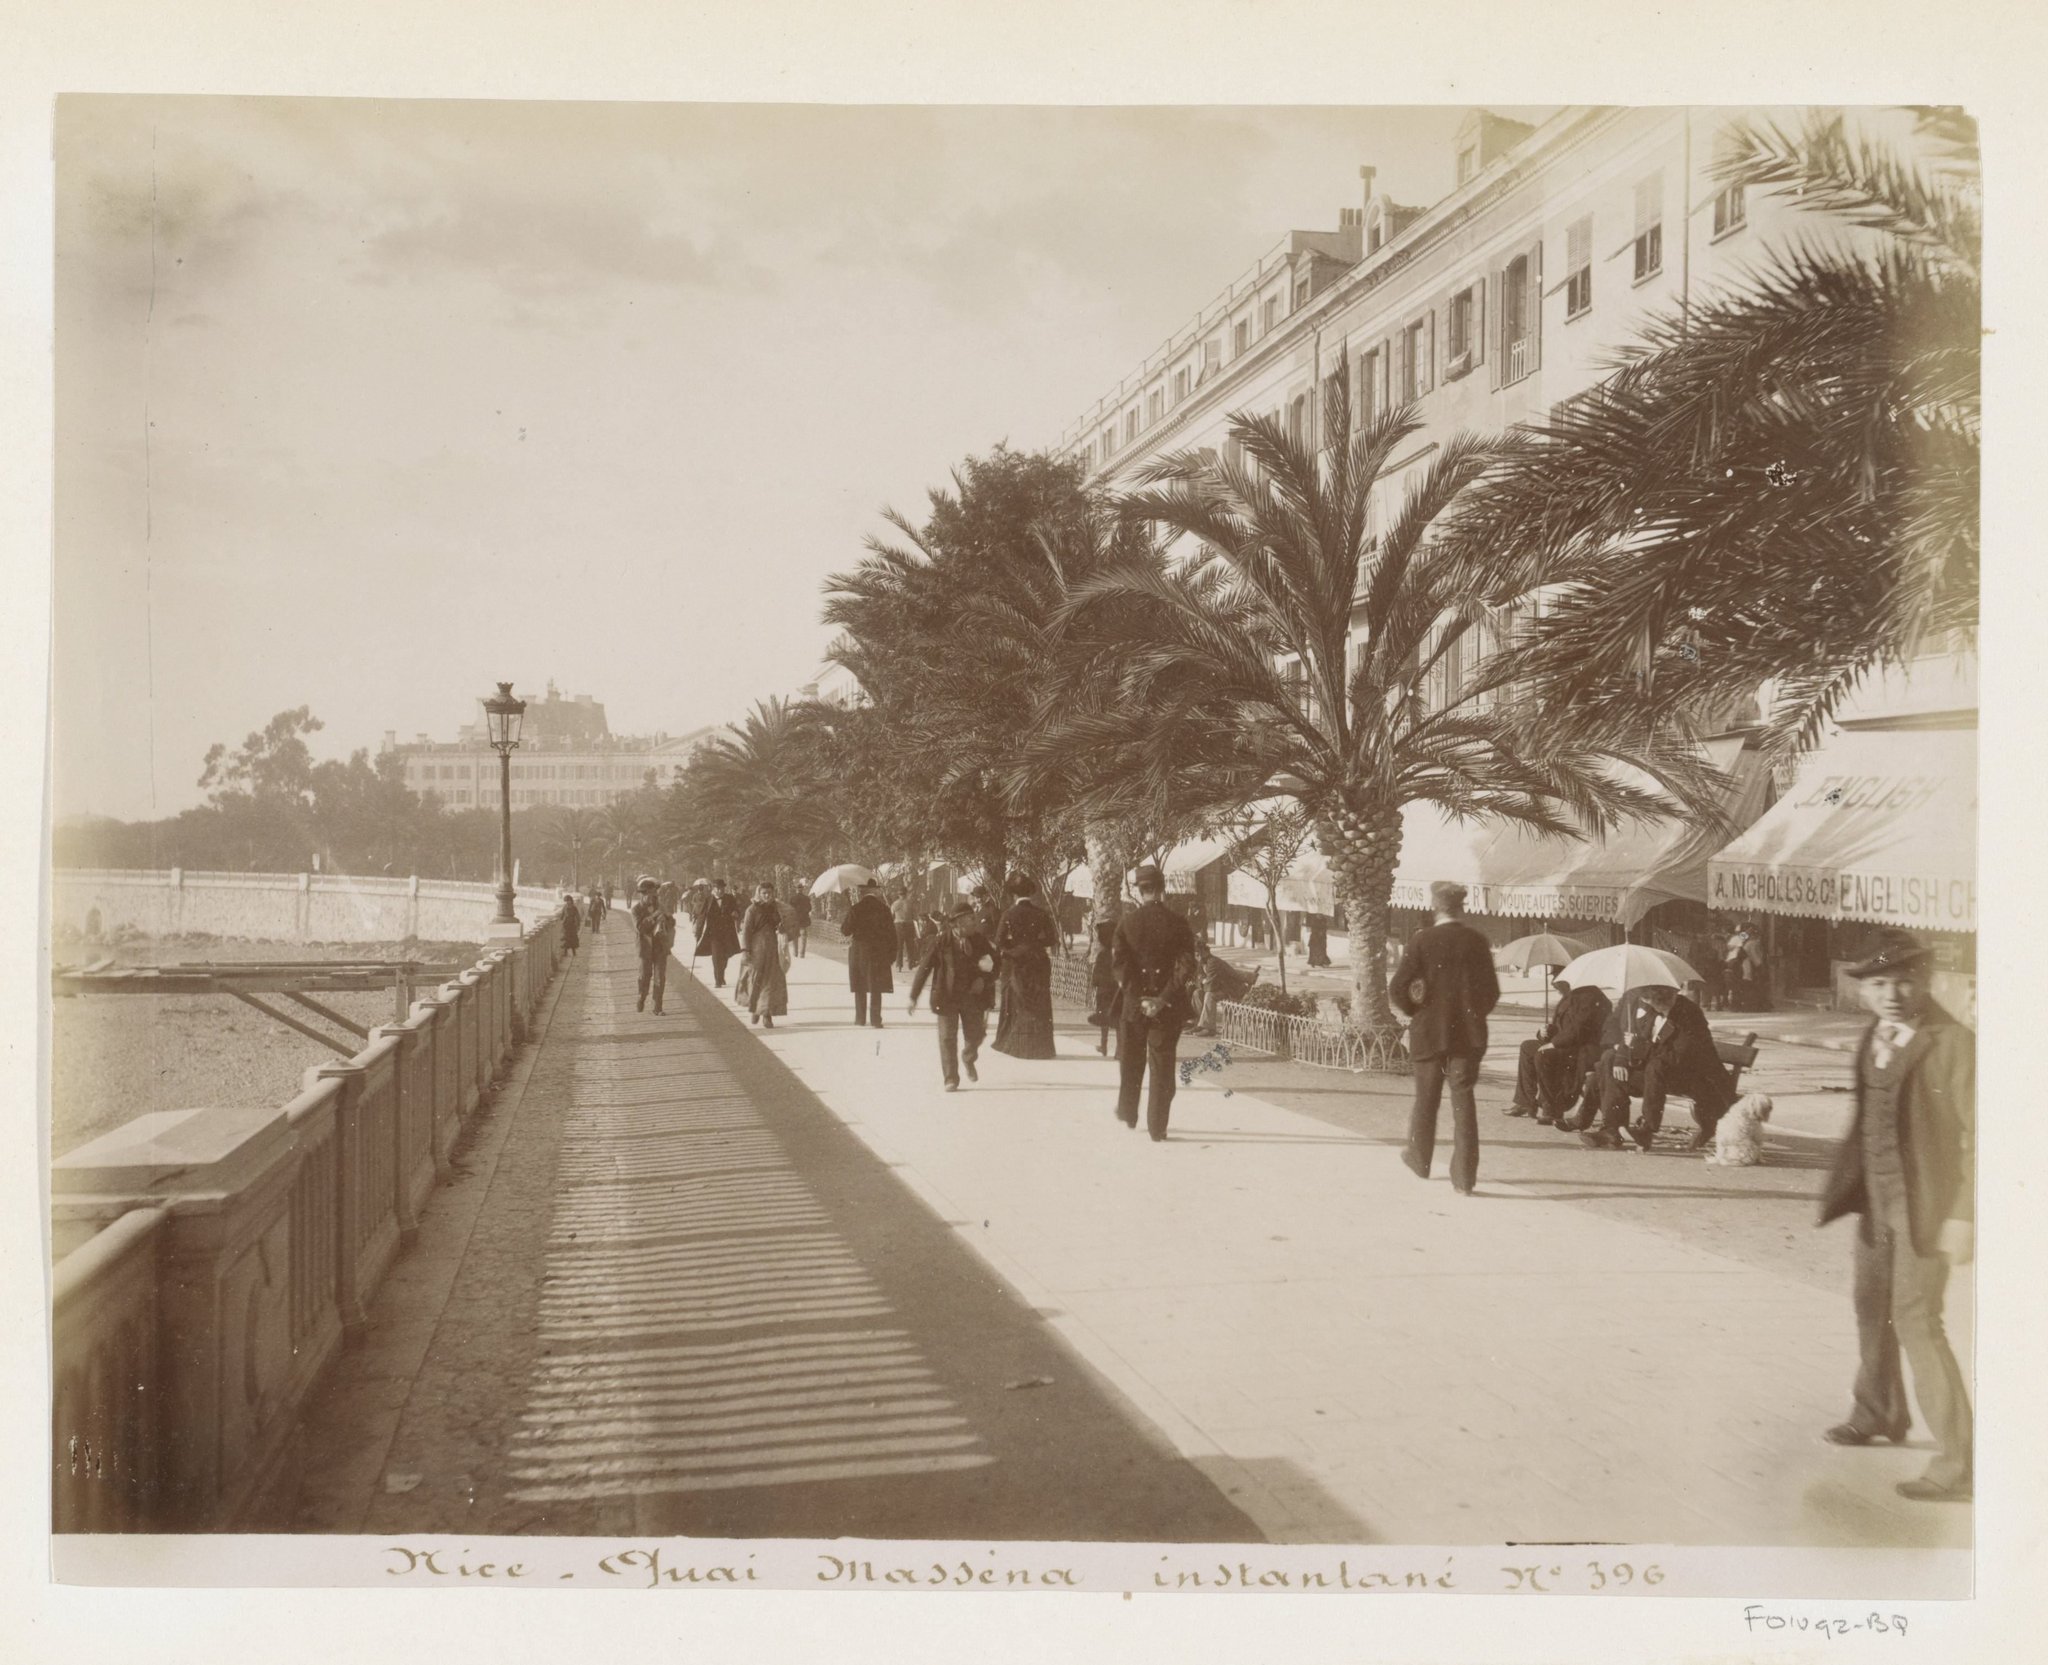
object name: photograph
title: Nice - Quai Masséna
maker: jean gilletta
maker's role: fotograaf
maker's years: 1856-1933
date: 1883-1892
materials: cardboard, paper, photographic support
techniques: albumen print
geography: nice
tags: shop, store, strolling, avenue, boulevard, promenade, esplanade (+ city(-scape) with figures, staffage), trees: palm-tree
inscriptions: negative number: ‘instantané No. 396’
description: Onderdeel van Reisalbum met foto's van bezienswaardigheden in België en Frankrijk.